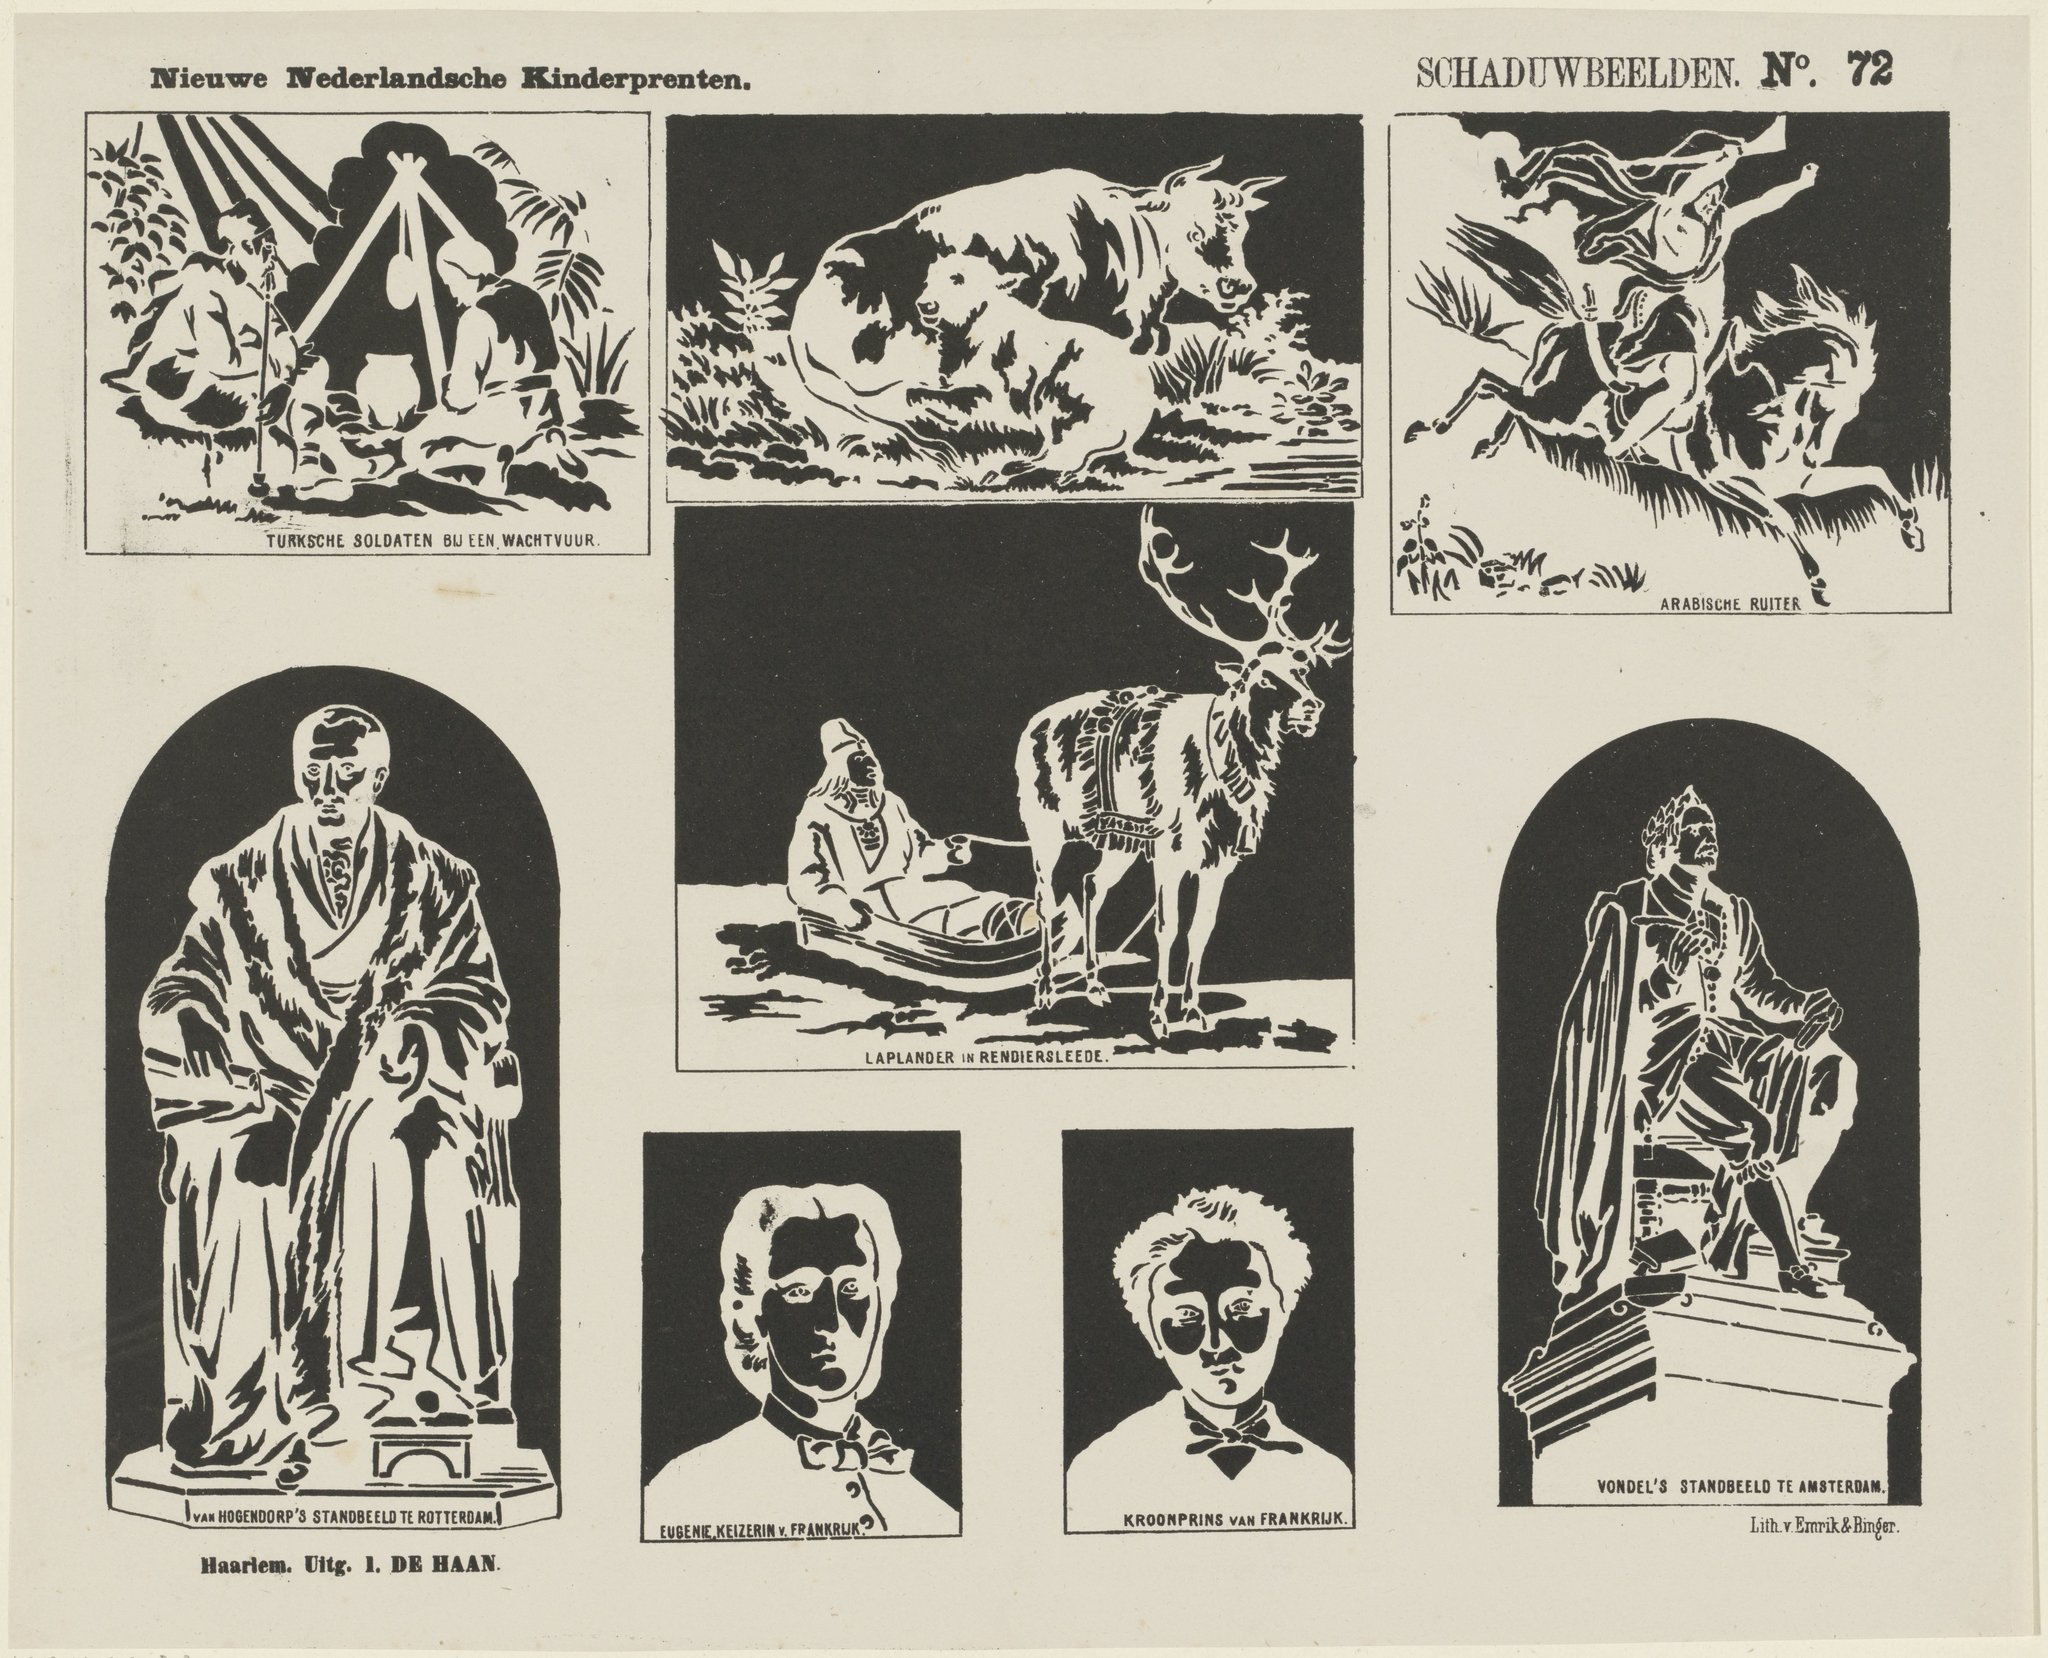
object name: print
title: Schaduwbeelden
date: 1875-1903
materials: paper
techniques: letterpress printing, lithograph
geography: haarlem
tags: sevilla, the hague, gijsbert karel graaf van hogendorp, paris, cologne, amsterdam, joost van den vondel, cow, the soldier; the soldier's life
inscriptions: collector's mark: Lugt 2760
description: Blad met 8 schaduwbeelden van onder andere portretten van historische figuren, koeien en Turkse soldaten. Genummerd rechtsboven: No. 72.